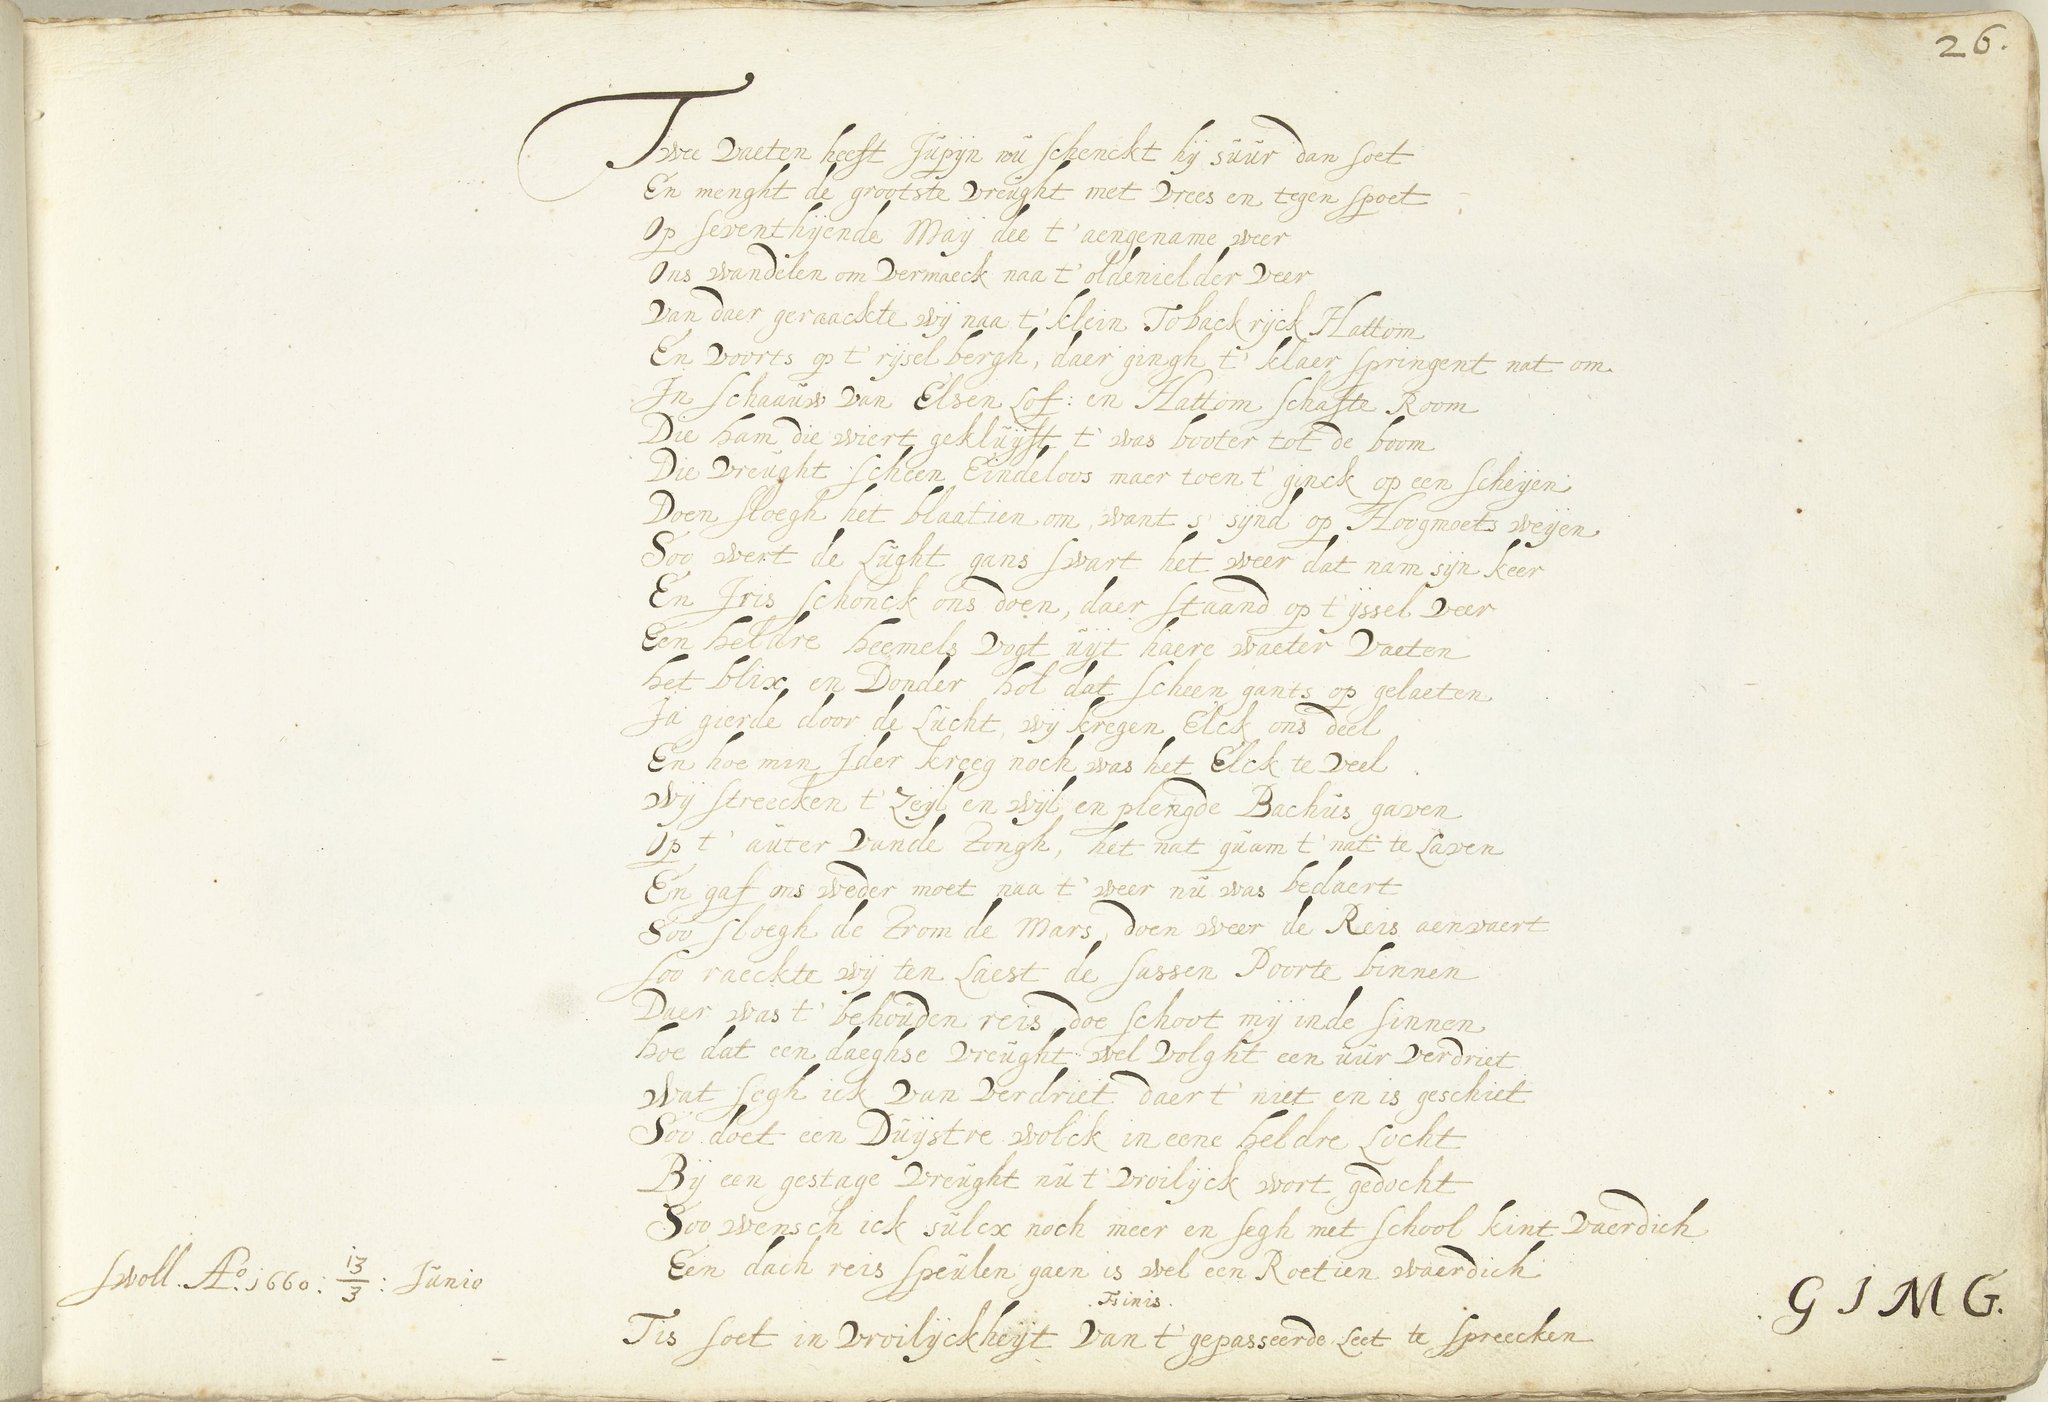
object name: poem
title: Gedicht over een pleziertochtje naar Hattem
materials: ink, paper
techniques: writing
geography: netherlands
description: Het gedicht is waarschijnlijk bedacht door iemand uit het gezelschap dat het pleziertochtje ondernam en later door Gesina in het Plakboek geschreven.